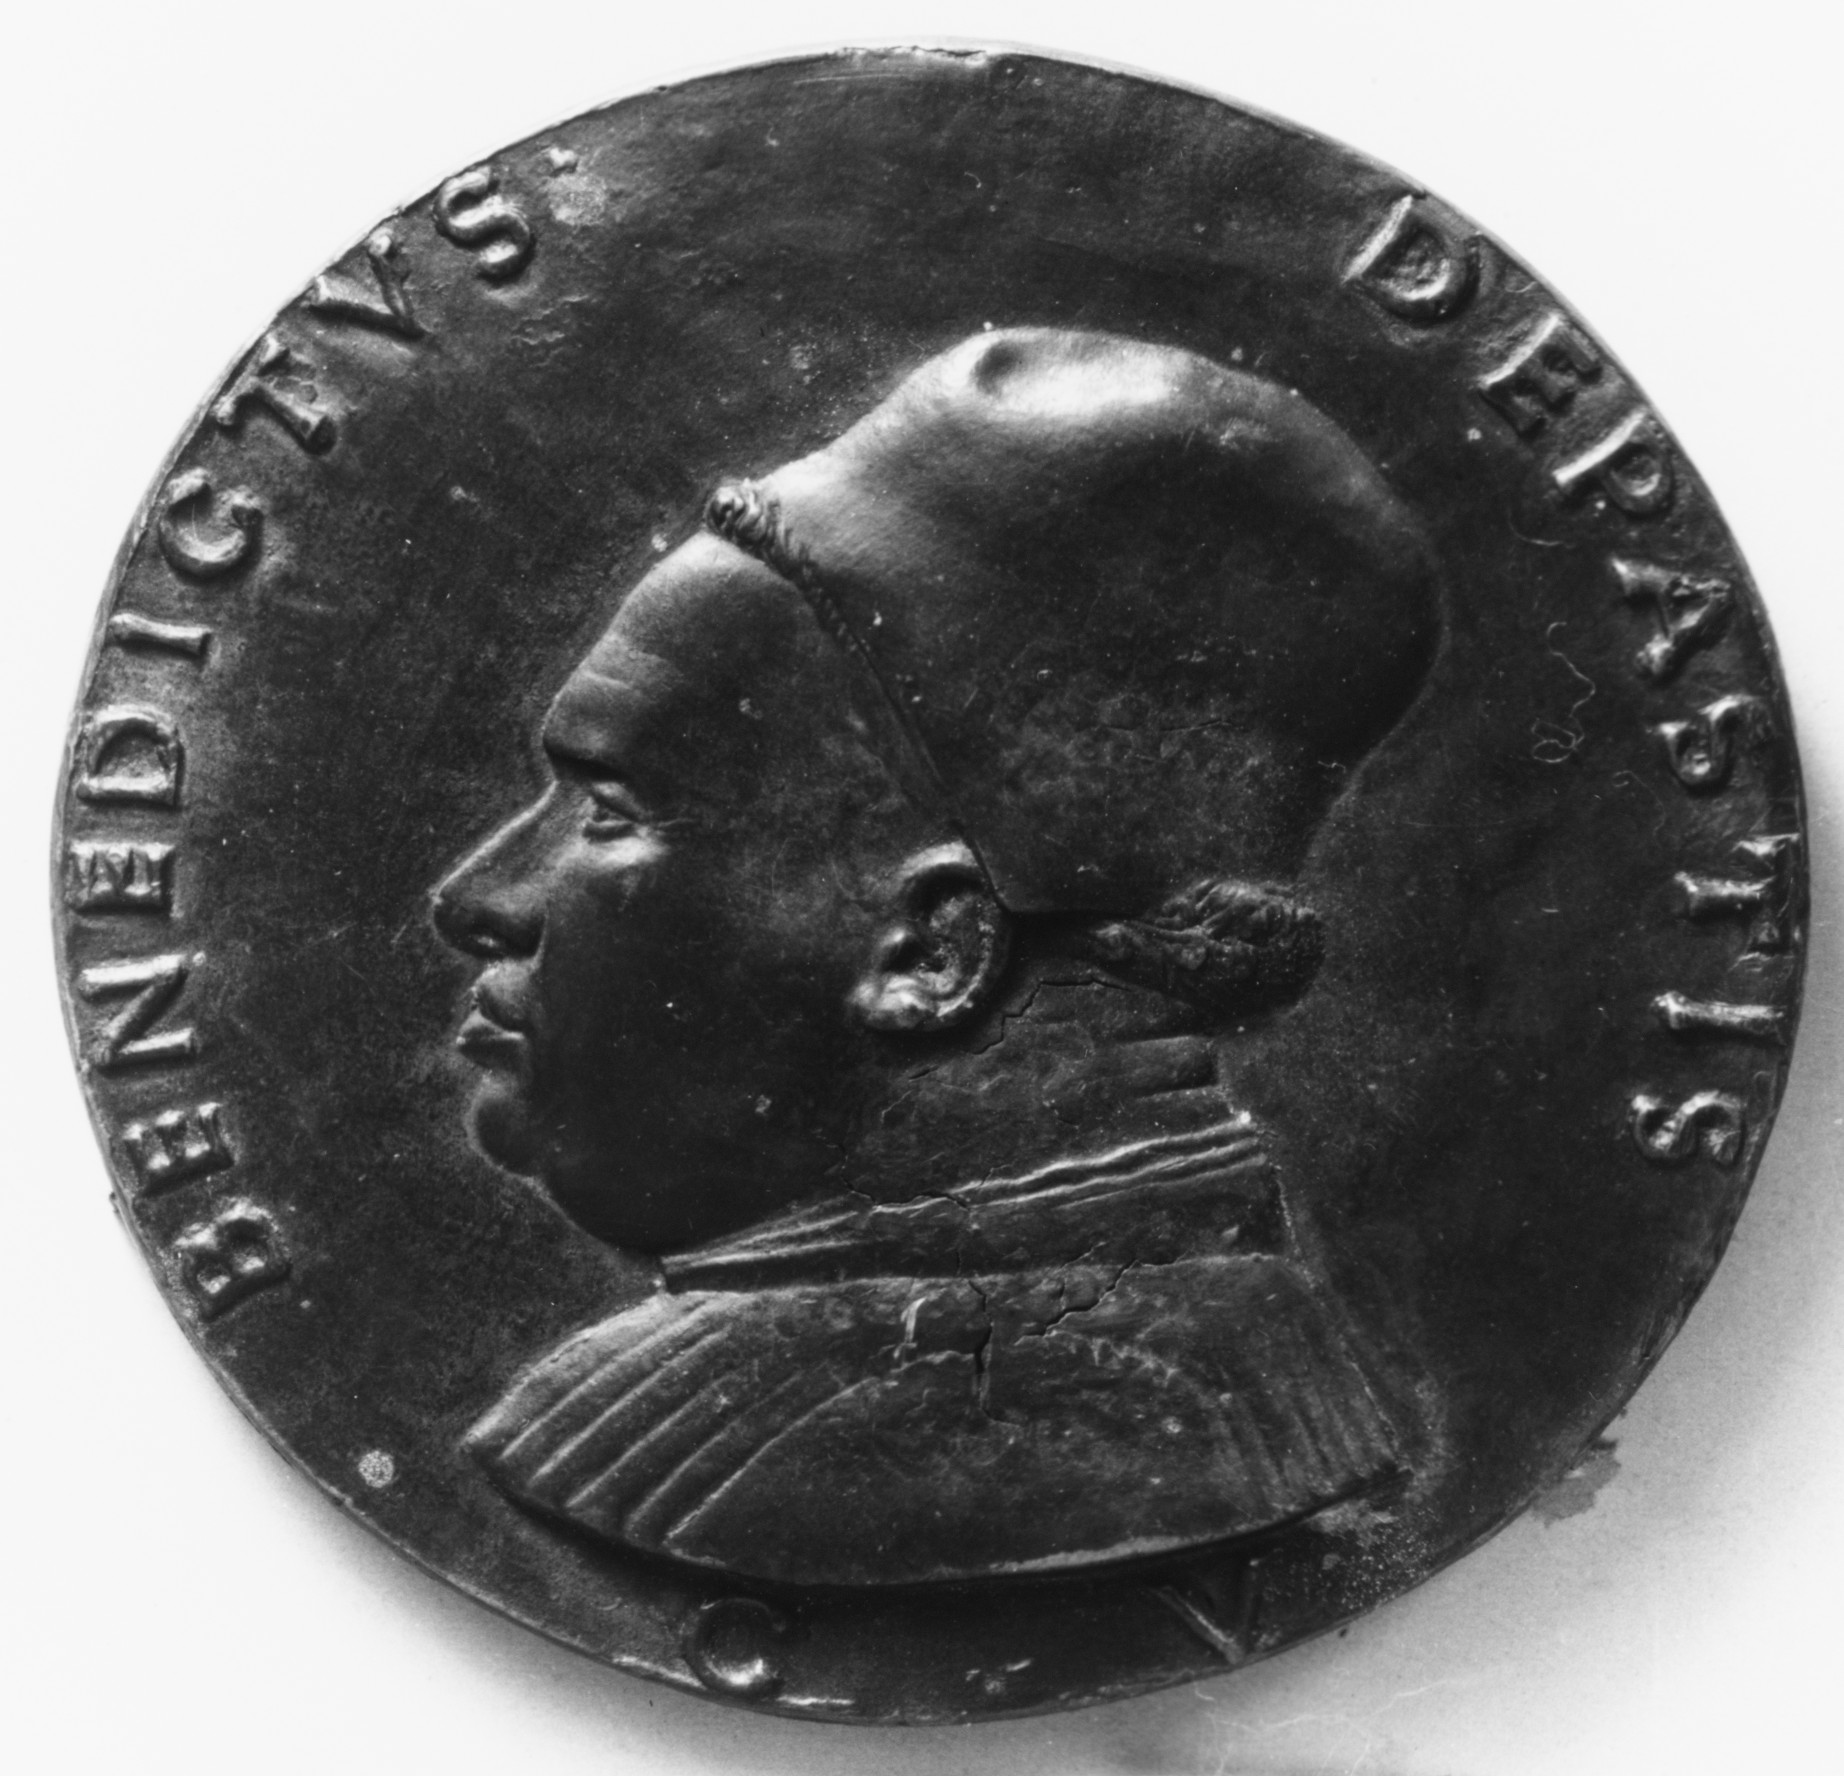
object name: medal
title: Benedetto de' Pasti, Canon of Verona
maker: matteo de' pasti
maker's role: artist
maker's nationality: italian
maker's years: 1420-1467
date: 1440-1444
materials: lead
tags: men,profiles